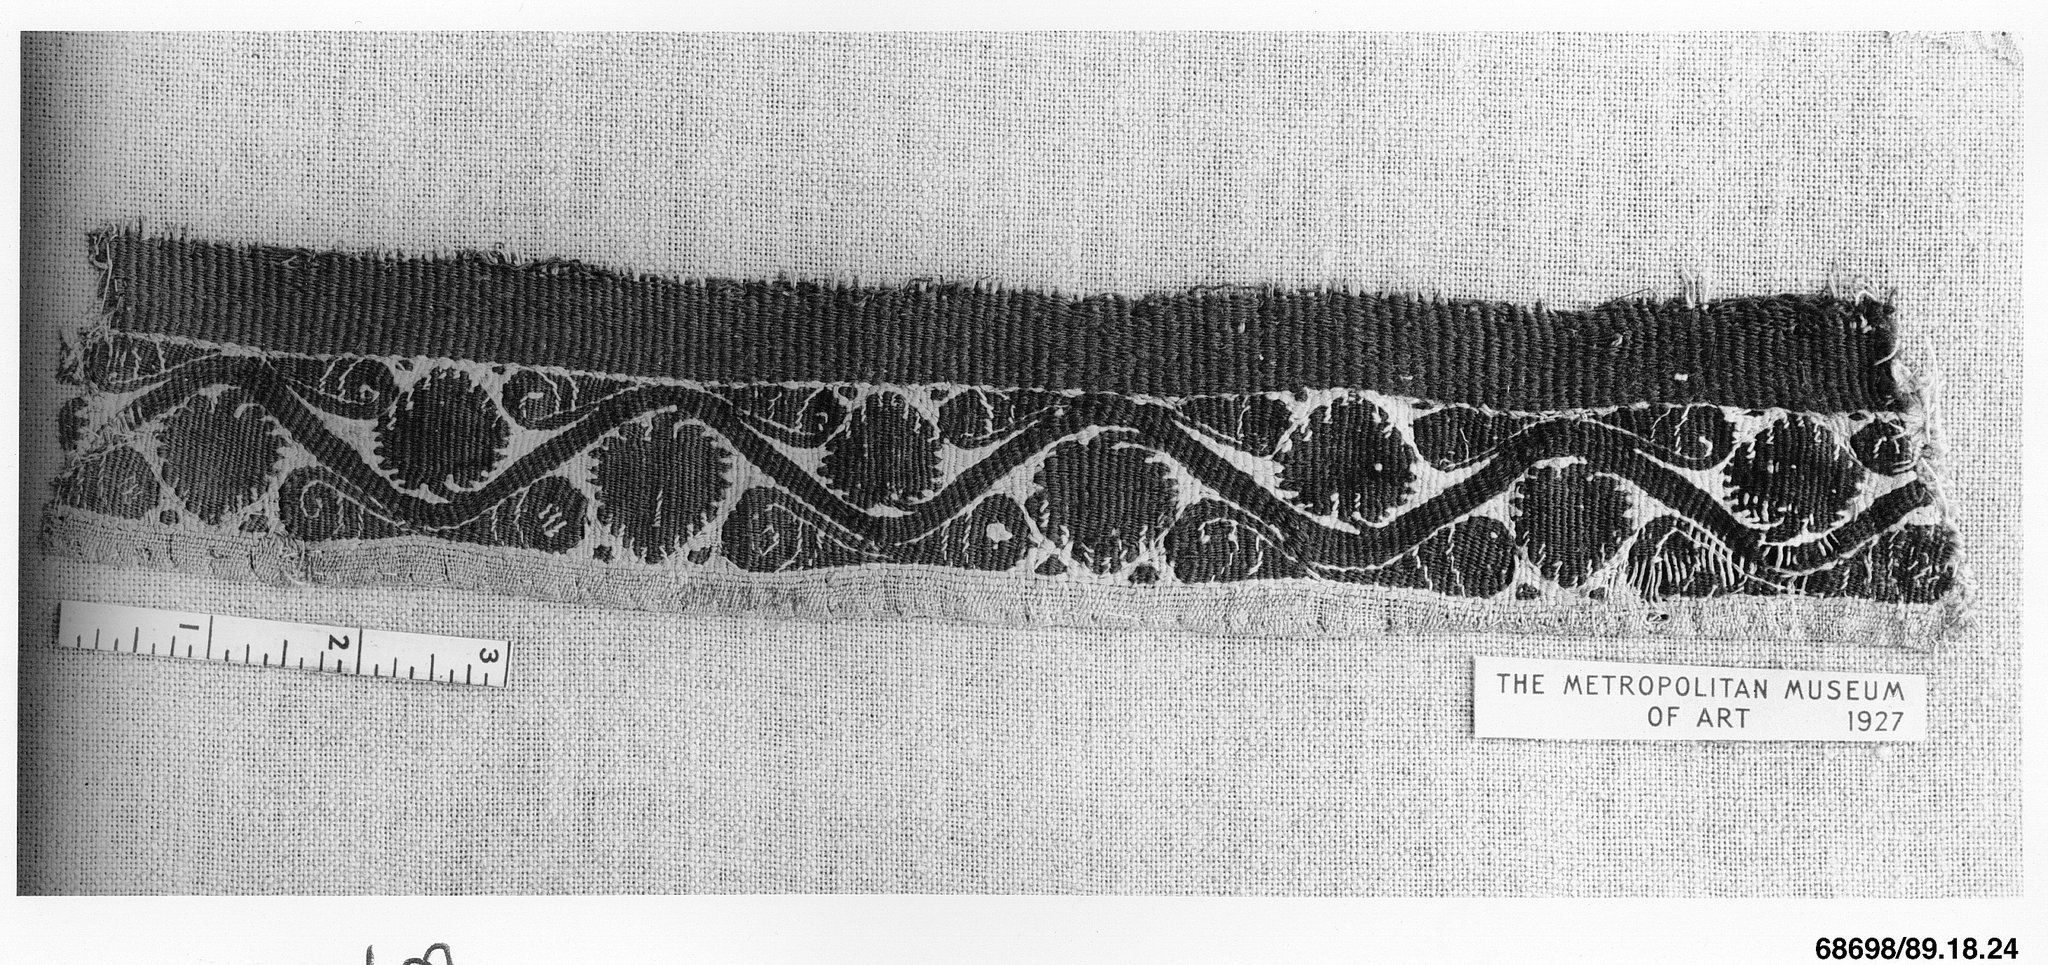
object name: textile fragment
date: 201-400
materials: linen, wool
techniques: weave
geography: egypt